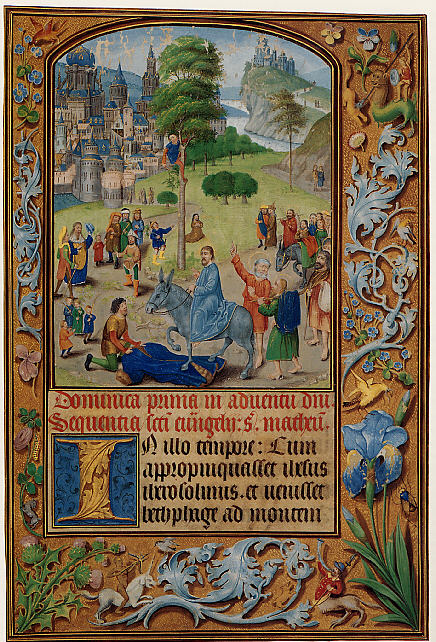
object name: leaf from an evangelary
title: Christ's Entry into Jerusalem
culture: southern netherlandish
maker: southern netherlands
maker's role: artist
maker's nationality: southern netherlands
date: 1480-1490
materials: gold, parchment, paint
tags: cities,horses,christ